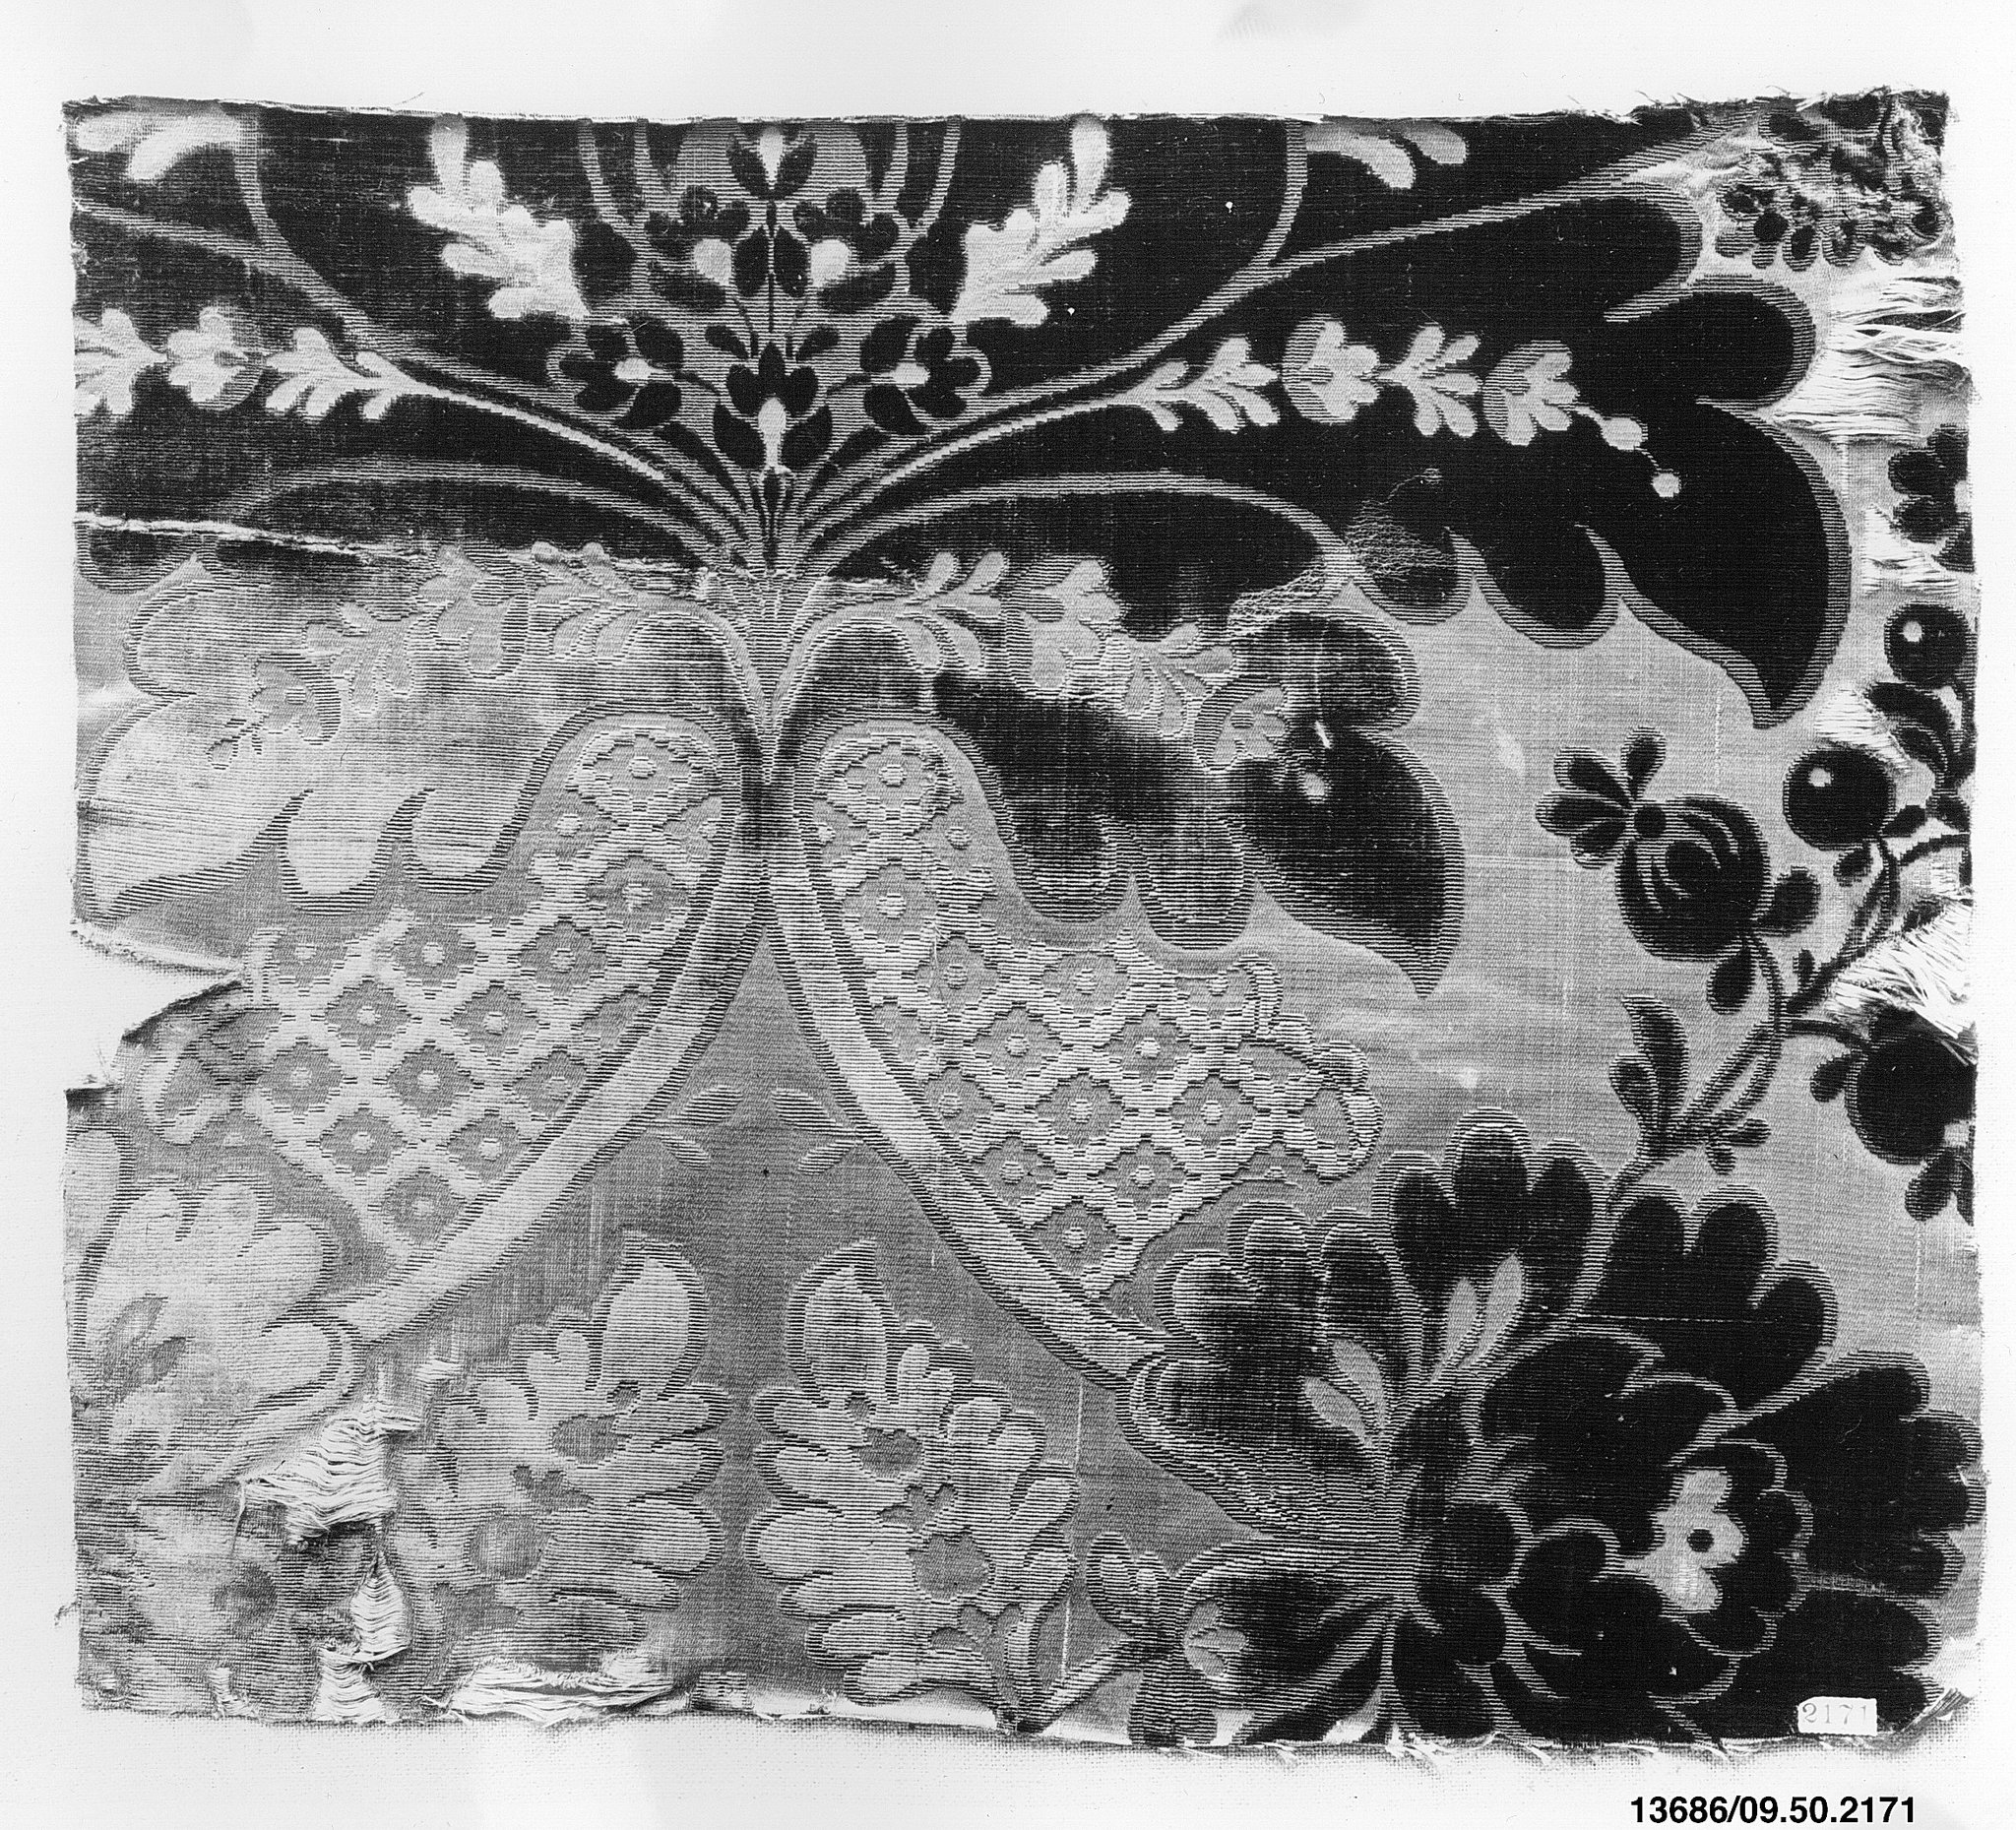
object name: piece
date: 1601-1700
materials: silk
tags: leaves